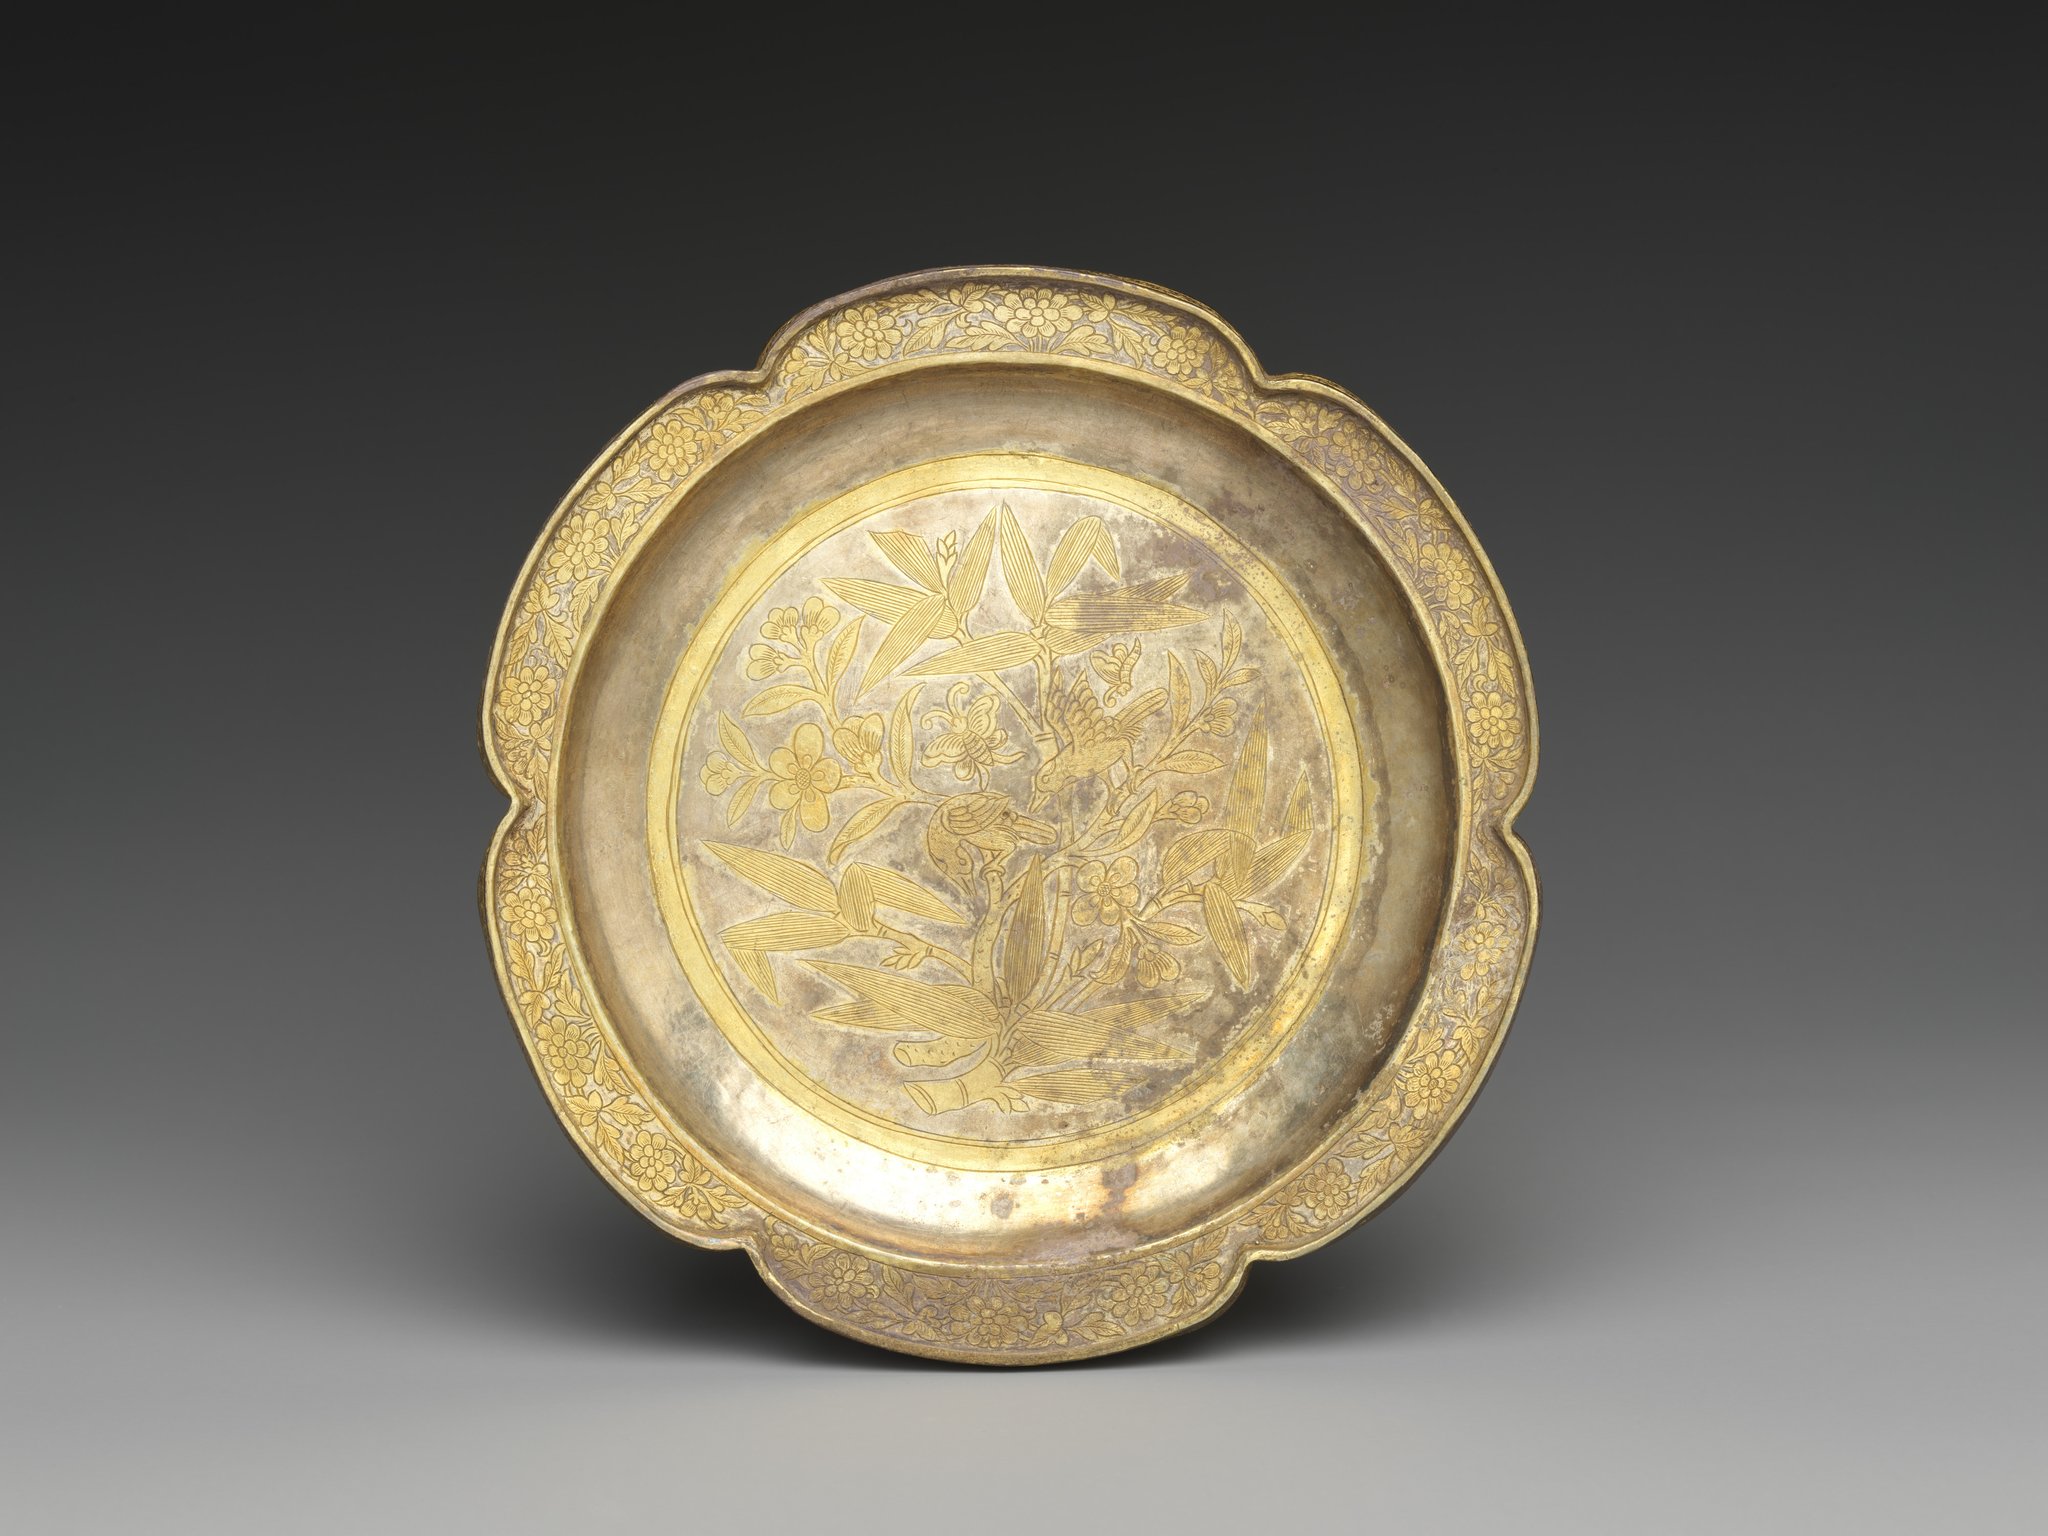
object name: dish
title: Lobed dish with flowers and birds (one from a set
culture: chinese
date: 1267-1400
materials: silver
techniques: chasing, gilding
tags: birds,butterflies,flowers,bamboo